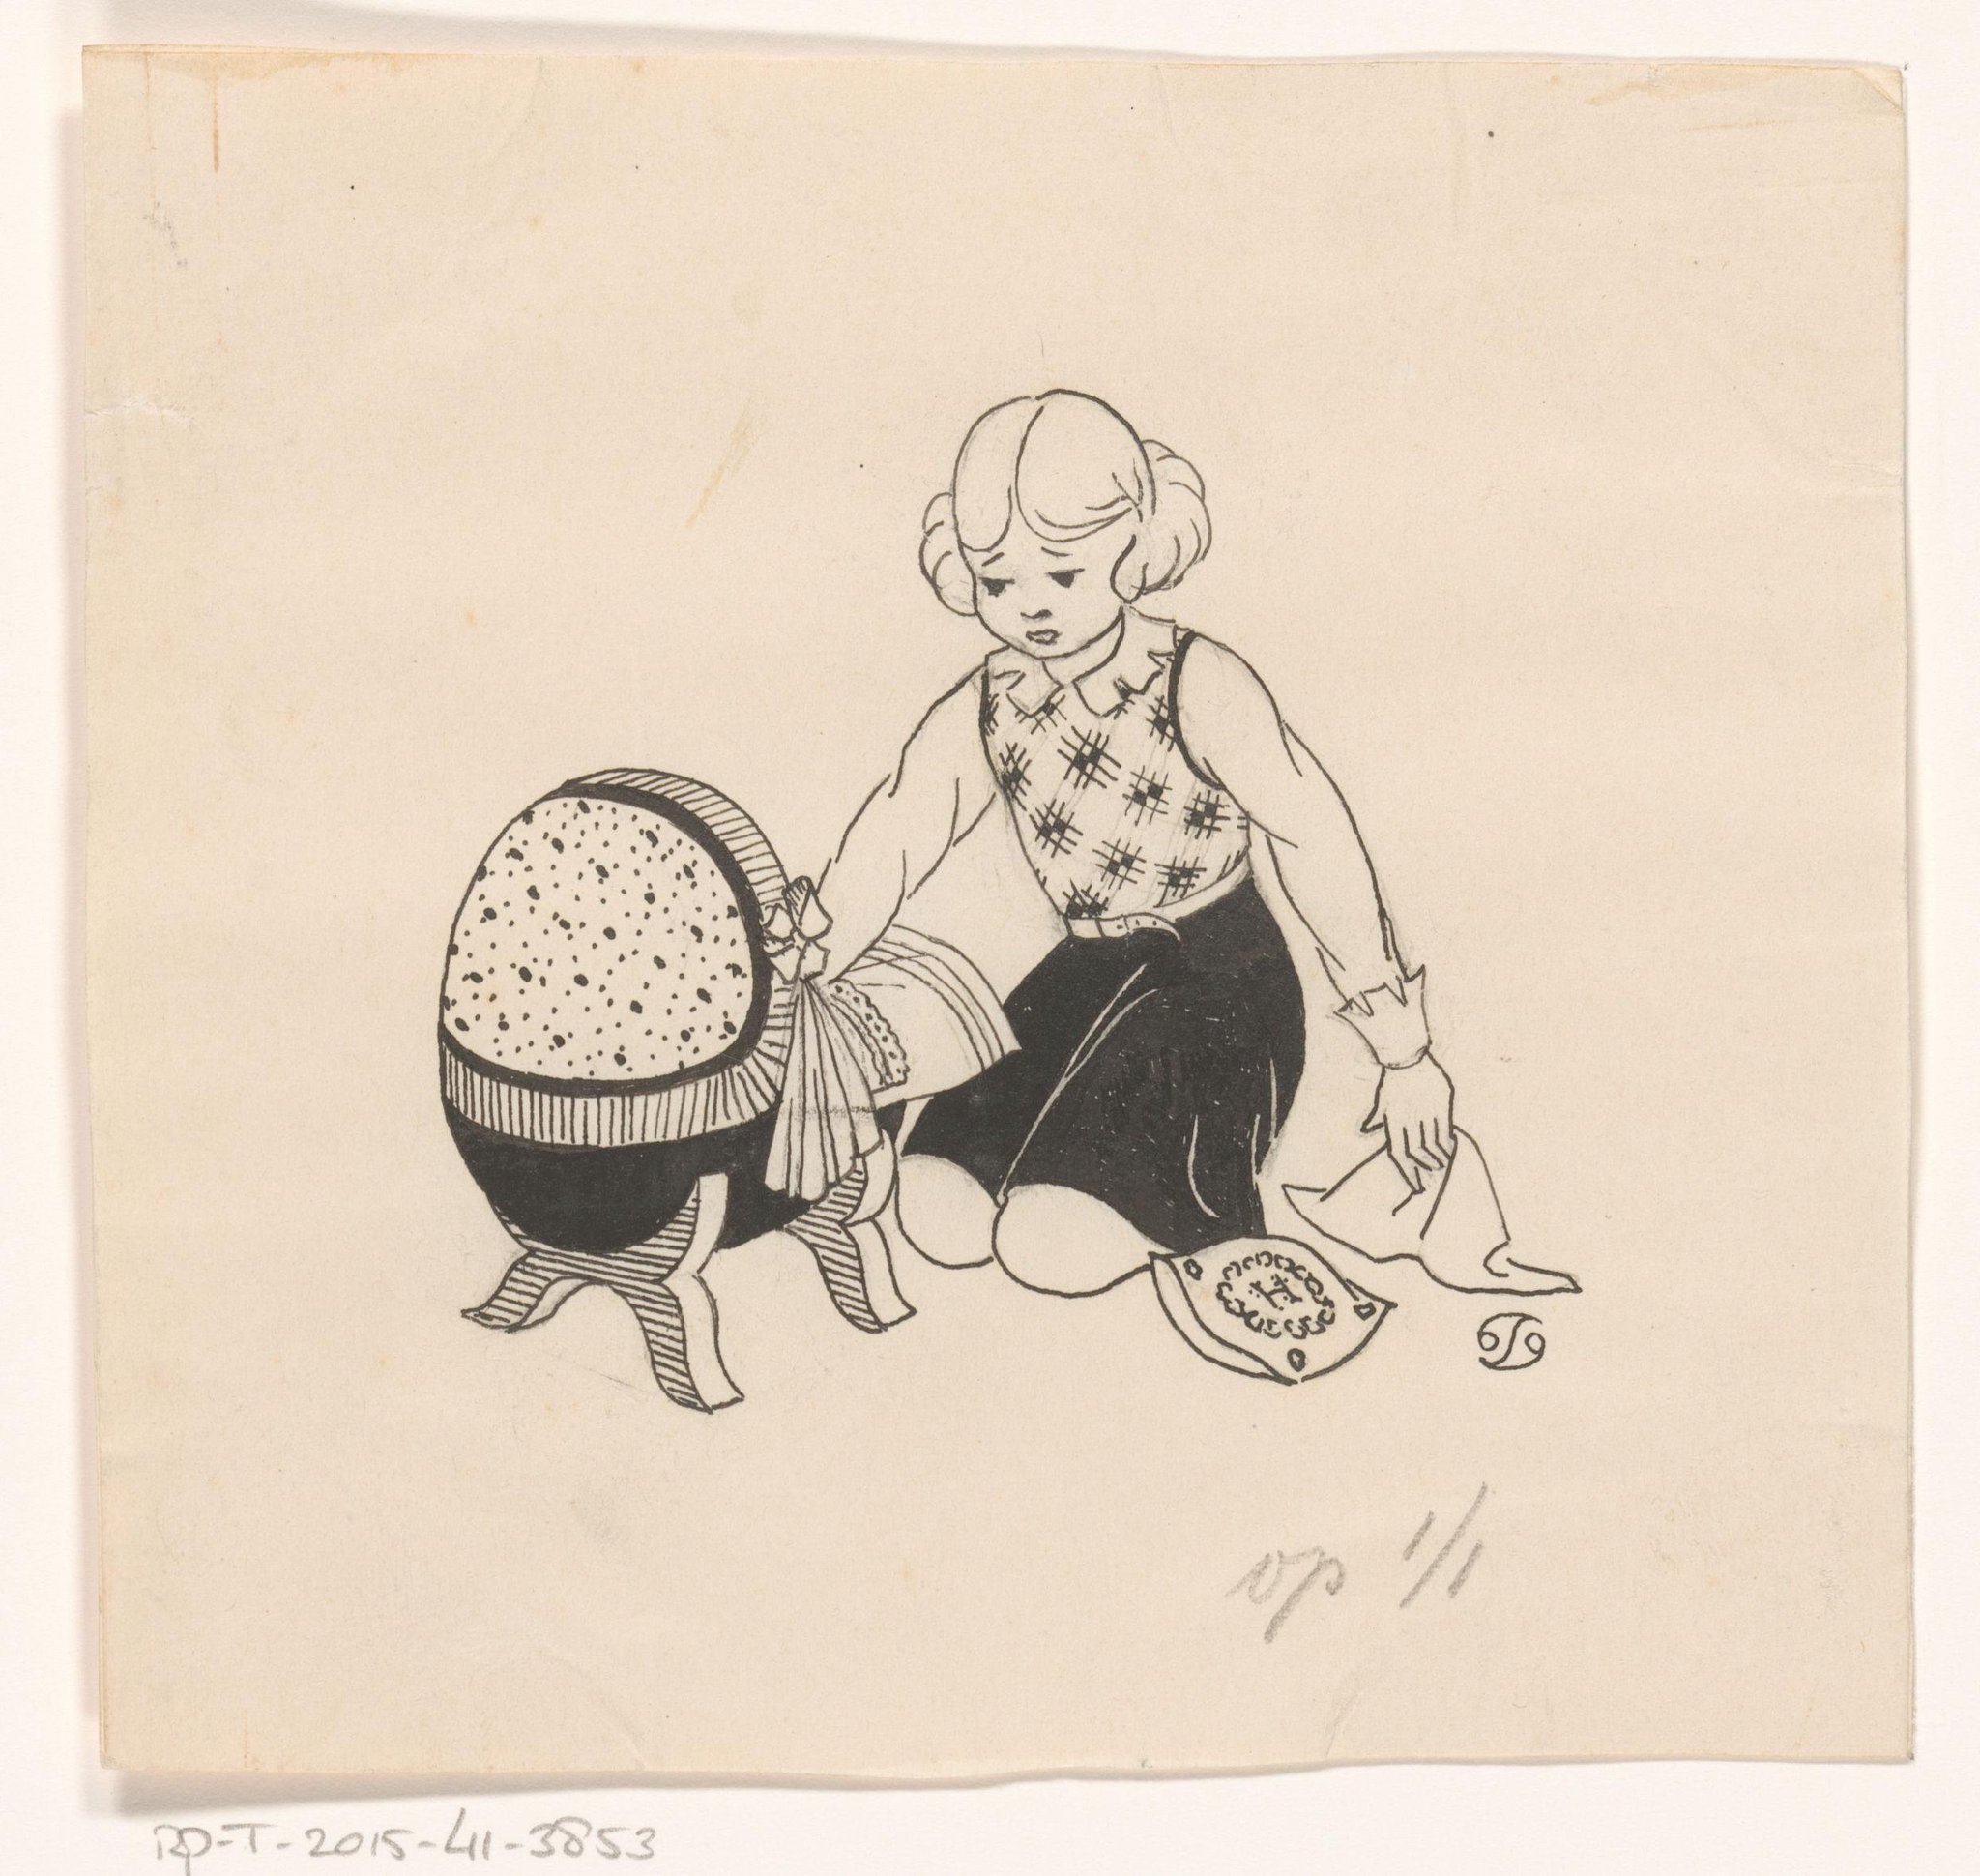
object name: boekillustratie ontwerp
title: Meisje knielt voor een poppenwieg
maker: Anonymous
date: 1890-1940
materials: ink, paper, pencil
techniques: brush, pen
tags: (playing with) dolls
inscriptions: monogram, annotation: ‘Popje's/ Wieg’